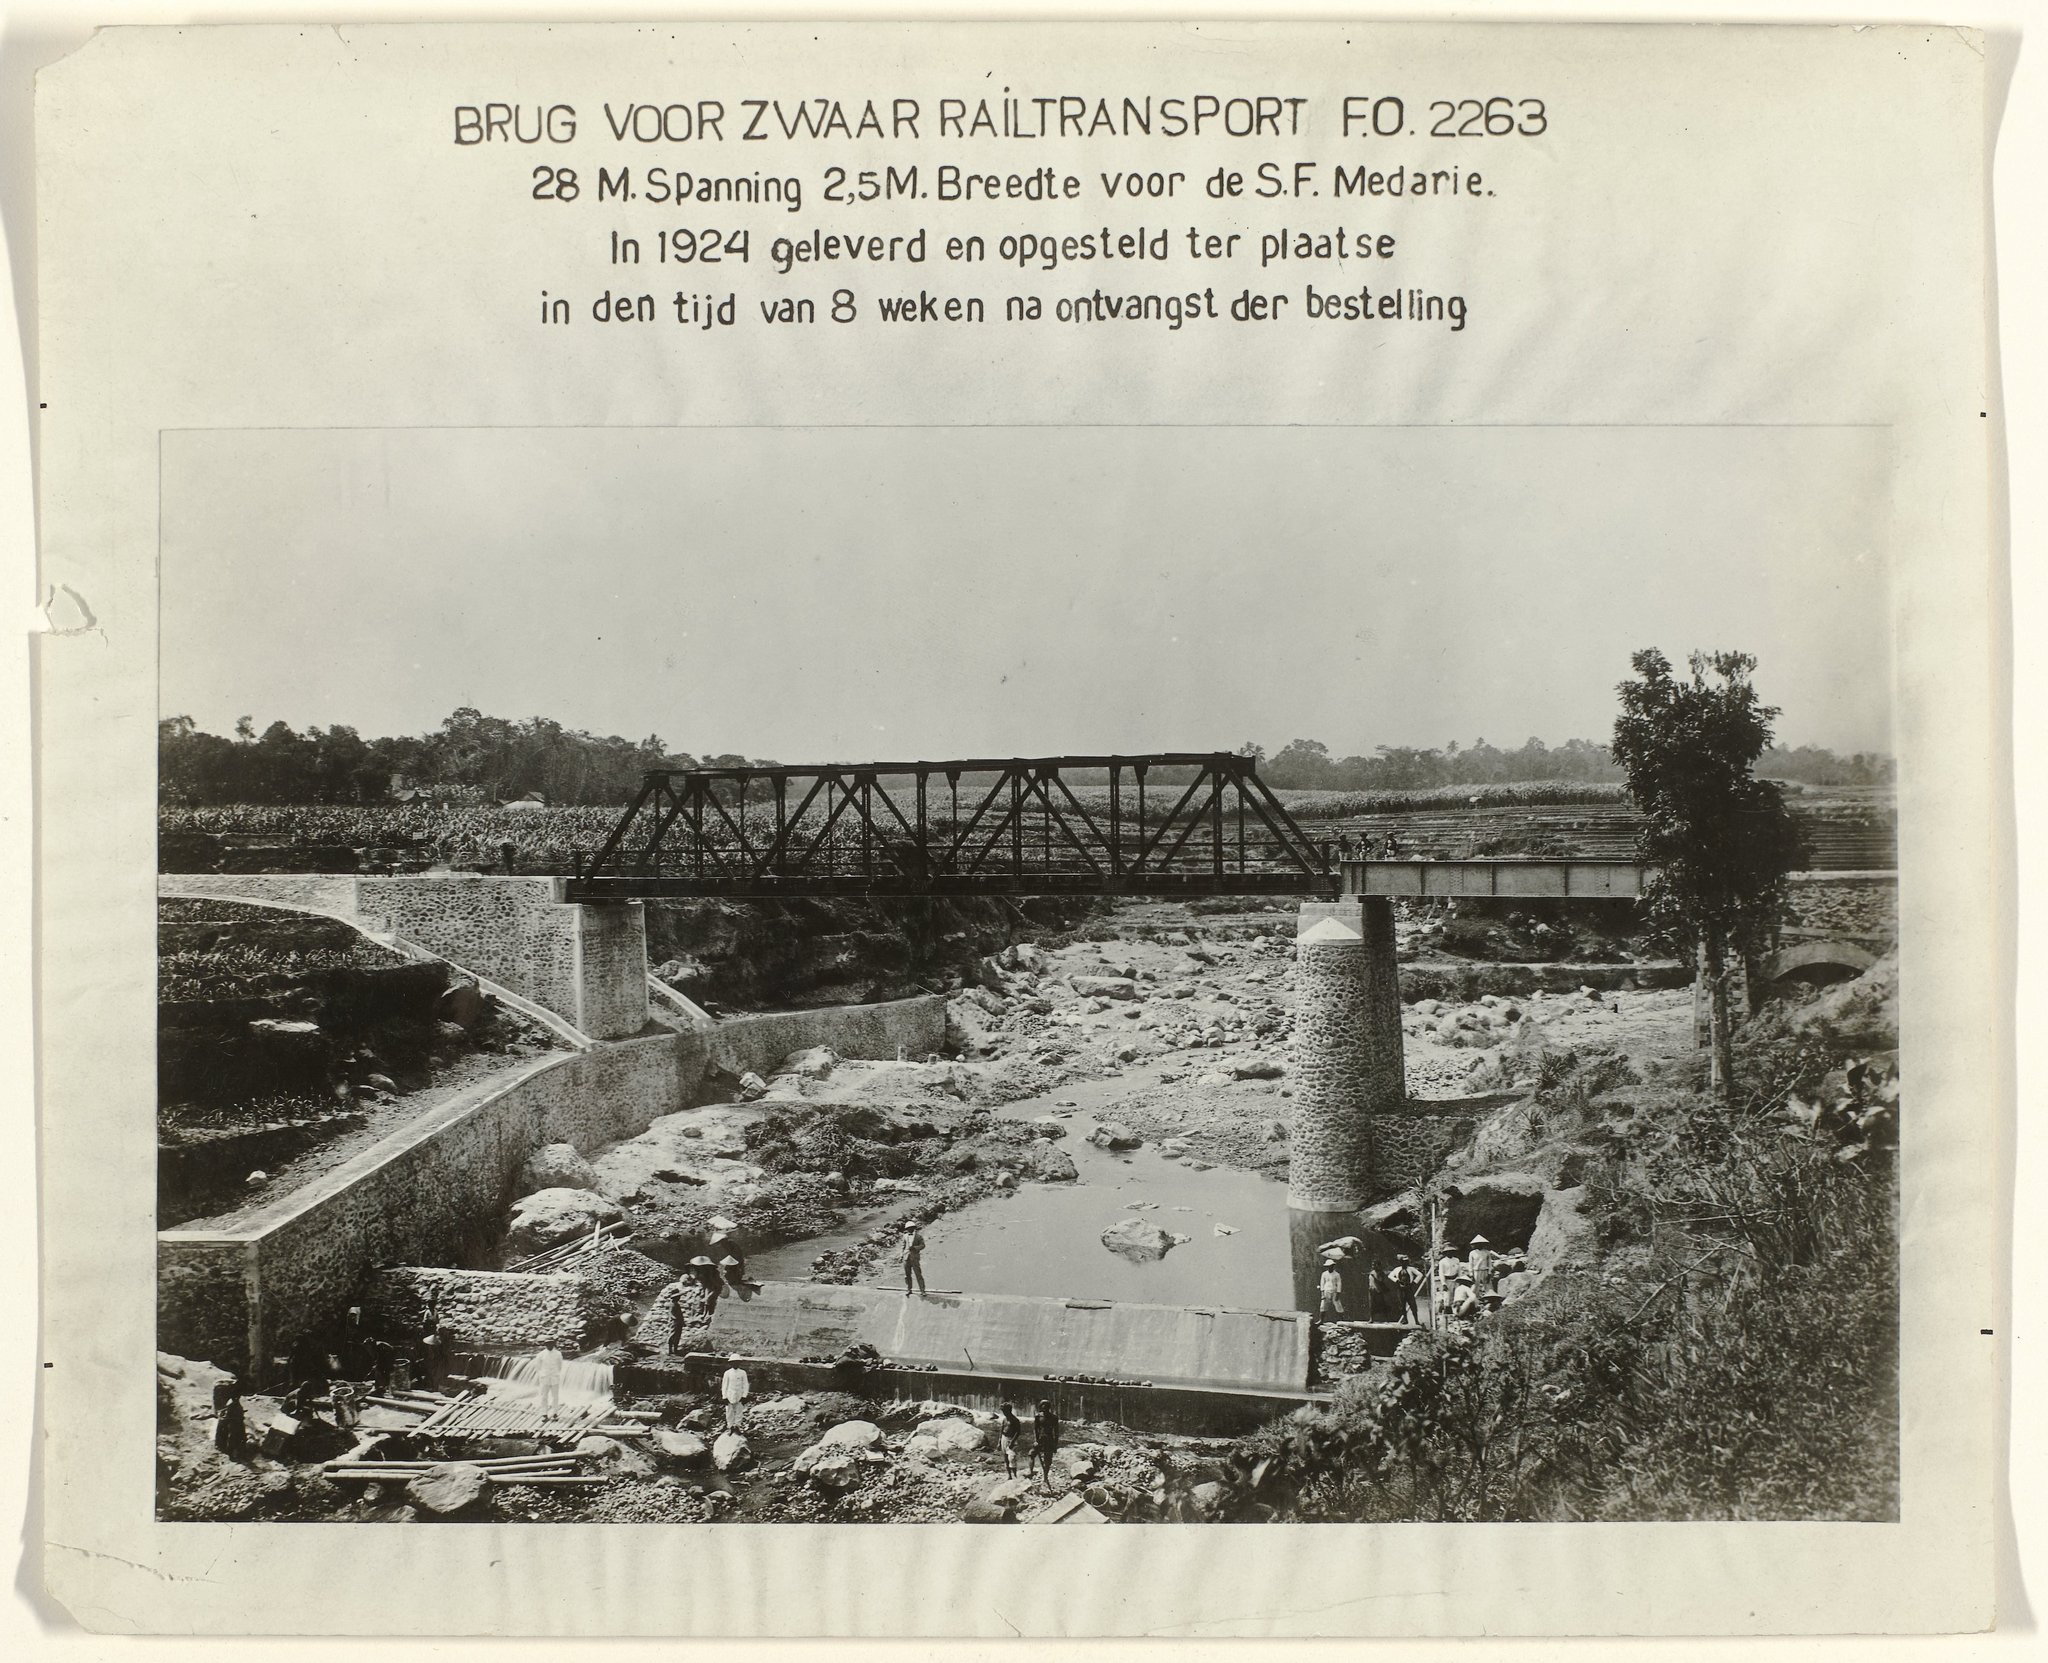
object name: photograph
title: Brug voor zwaar railtransport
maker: Anonymous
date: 1924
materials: photographic support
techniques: gelatin silver print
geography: jogjakarta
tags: colonial system, bridge, java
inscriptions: date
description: Brug voor zwaar railtransport over een ravijn met rivier. Brug met een spanning van 28 meter, geleverd in 1924, voor de Suikerfabriek Medarie te Yogyakarta. Onderdeel van een groep van losse, grotere foto's van verschillende soorten machines van de N.V. Machinefabriek Braat te Soerabaja, uit de periode ca. 1920-1940.